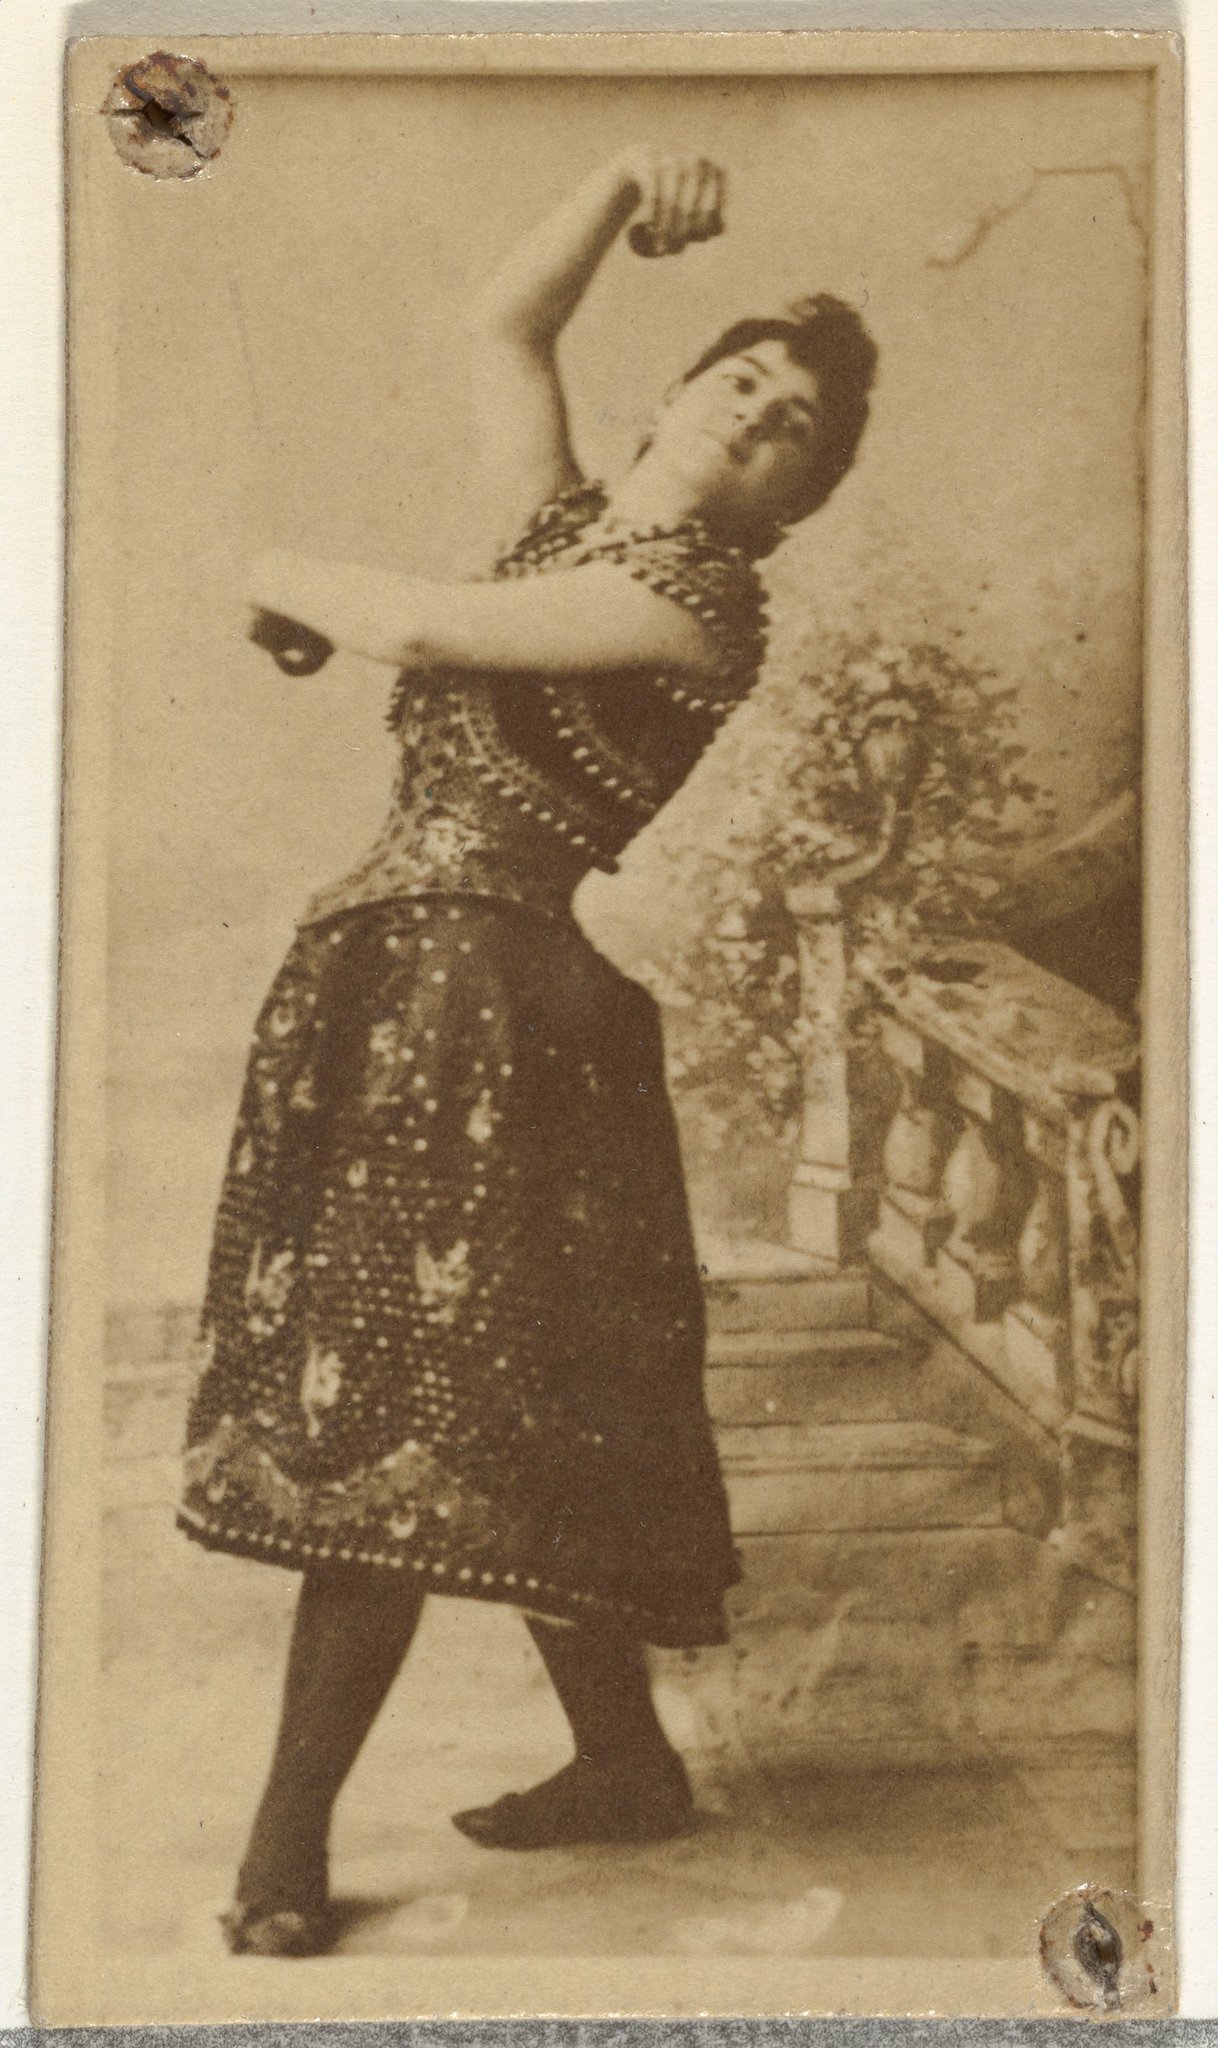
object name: photograph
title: [Dancer], from the Actors and Actresses series (N145-8) issued by Duke Sons & Co. to promote Duke Cigarettes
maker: w. duke, sons & co.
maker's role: publisher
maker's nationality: american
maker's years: 1870-1920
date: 1891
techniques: albumen silver print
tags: portraits,women,actresses